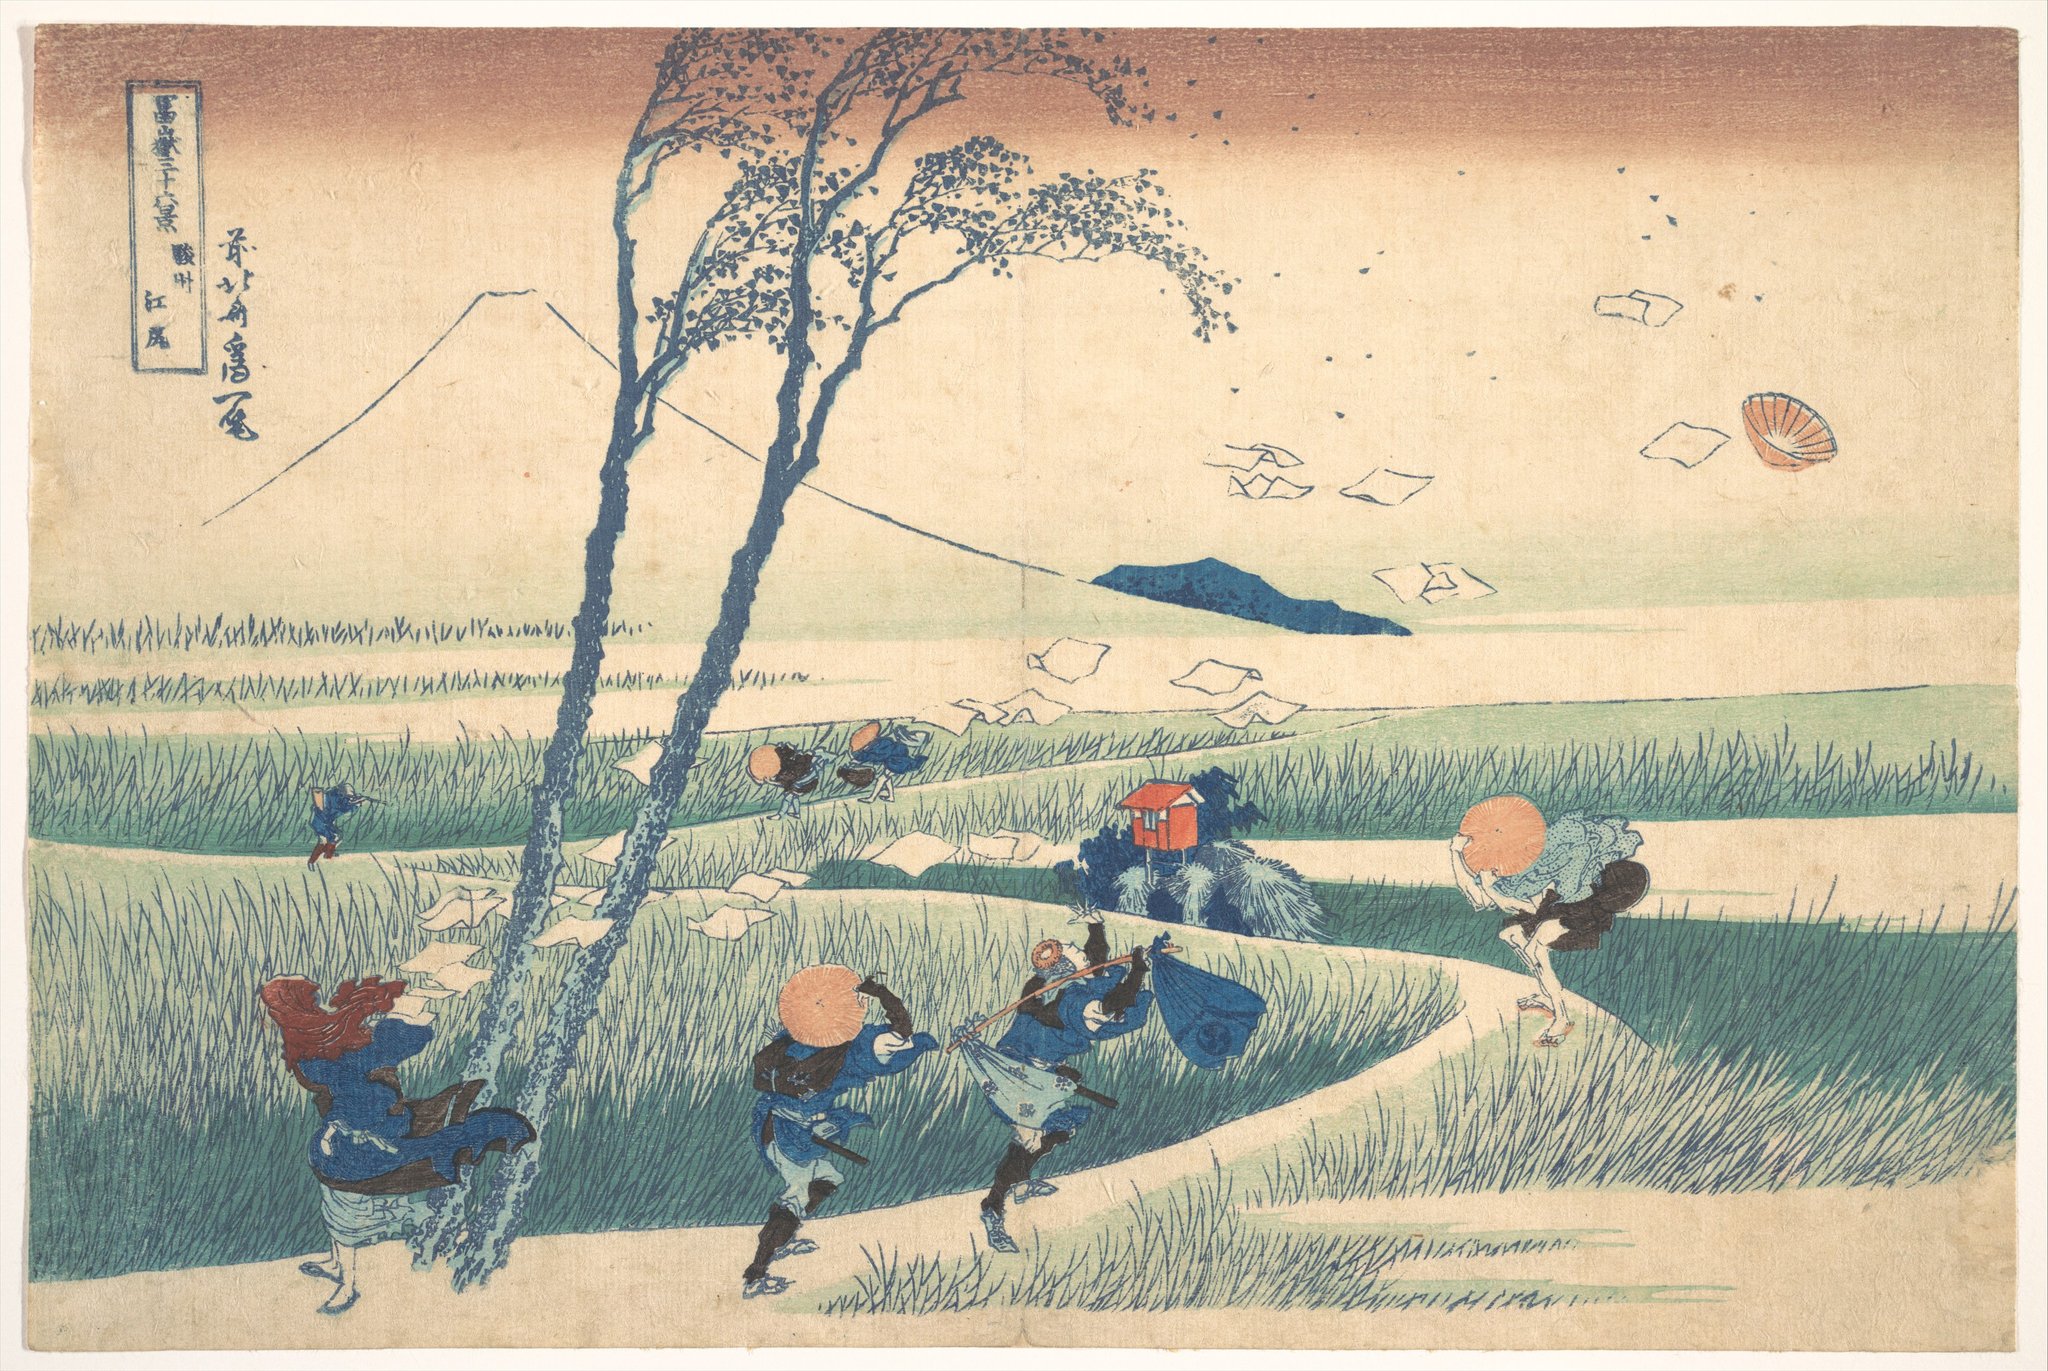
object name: woodblock print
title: Ejiri in Suruga Province (Sunshū Ejiri), from the series Thirty-six Views of Mount Fuji (Fugaku sanjūrokkei)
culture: japanese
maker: katsushika hokusai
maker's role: artist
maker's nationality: japanese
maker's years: 1760-1849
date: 1830-1832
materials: ink, paper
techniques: woodblock print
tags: men,mountains,trees,wind